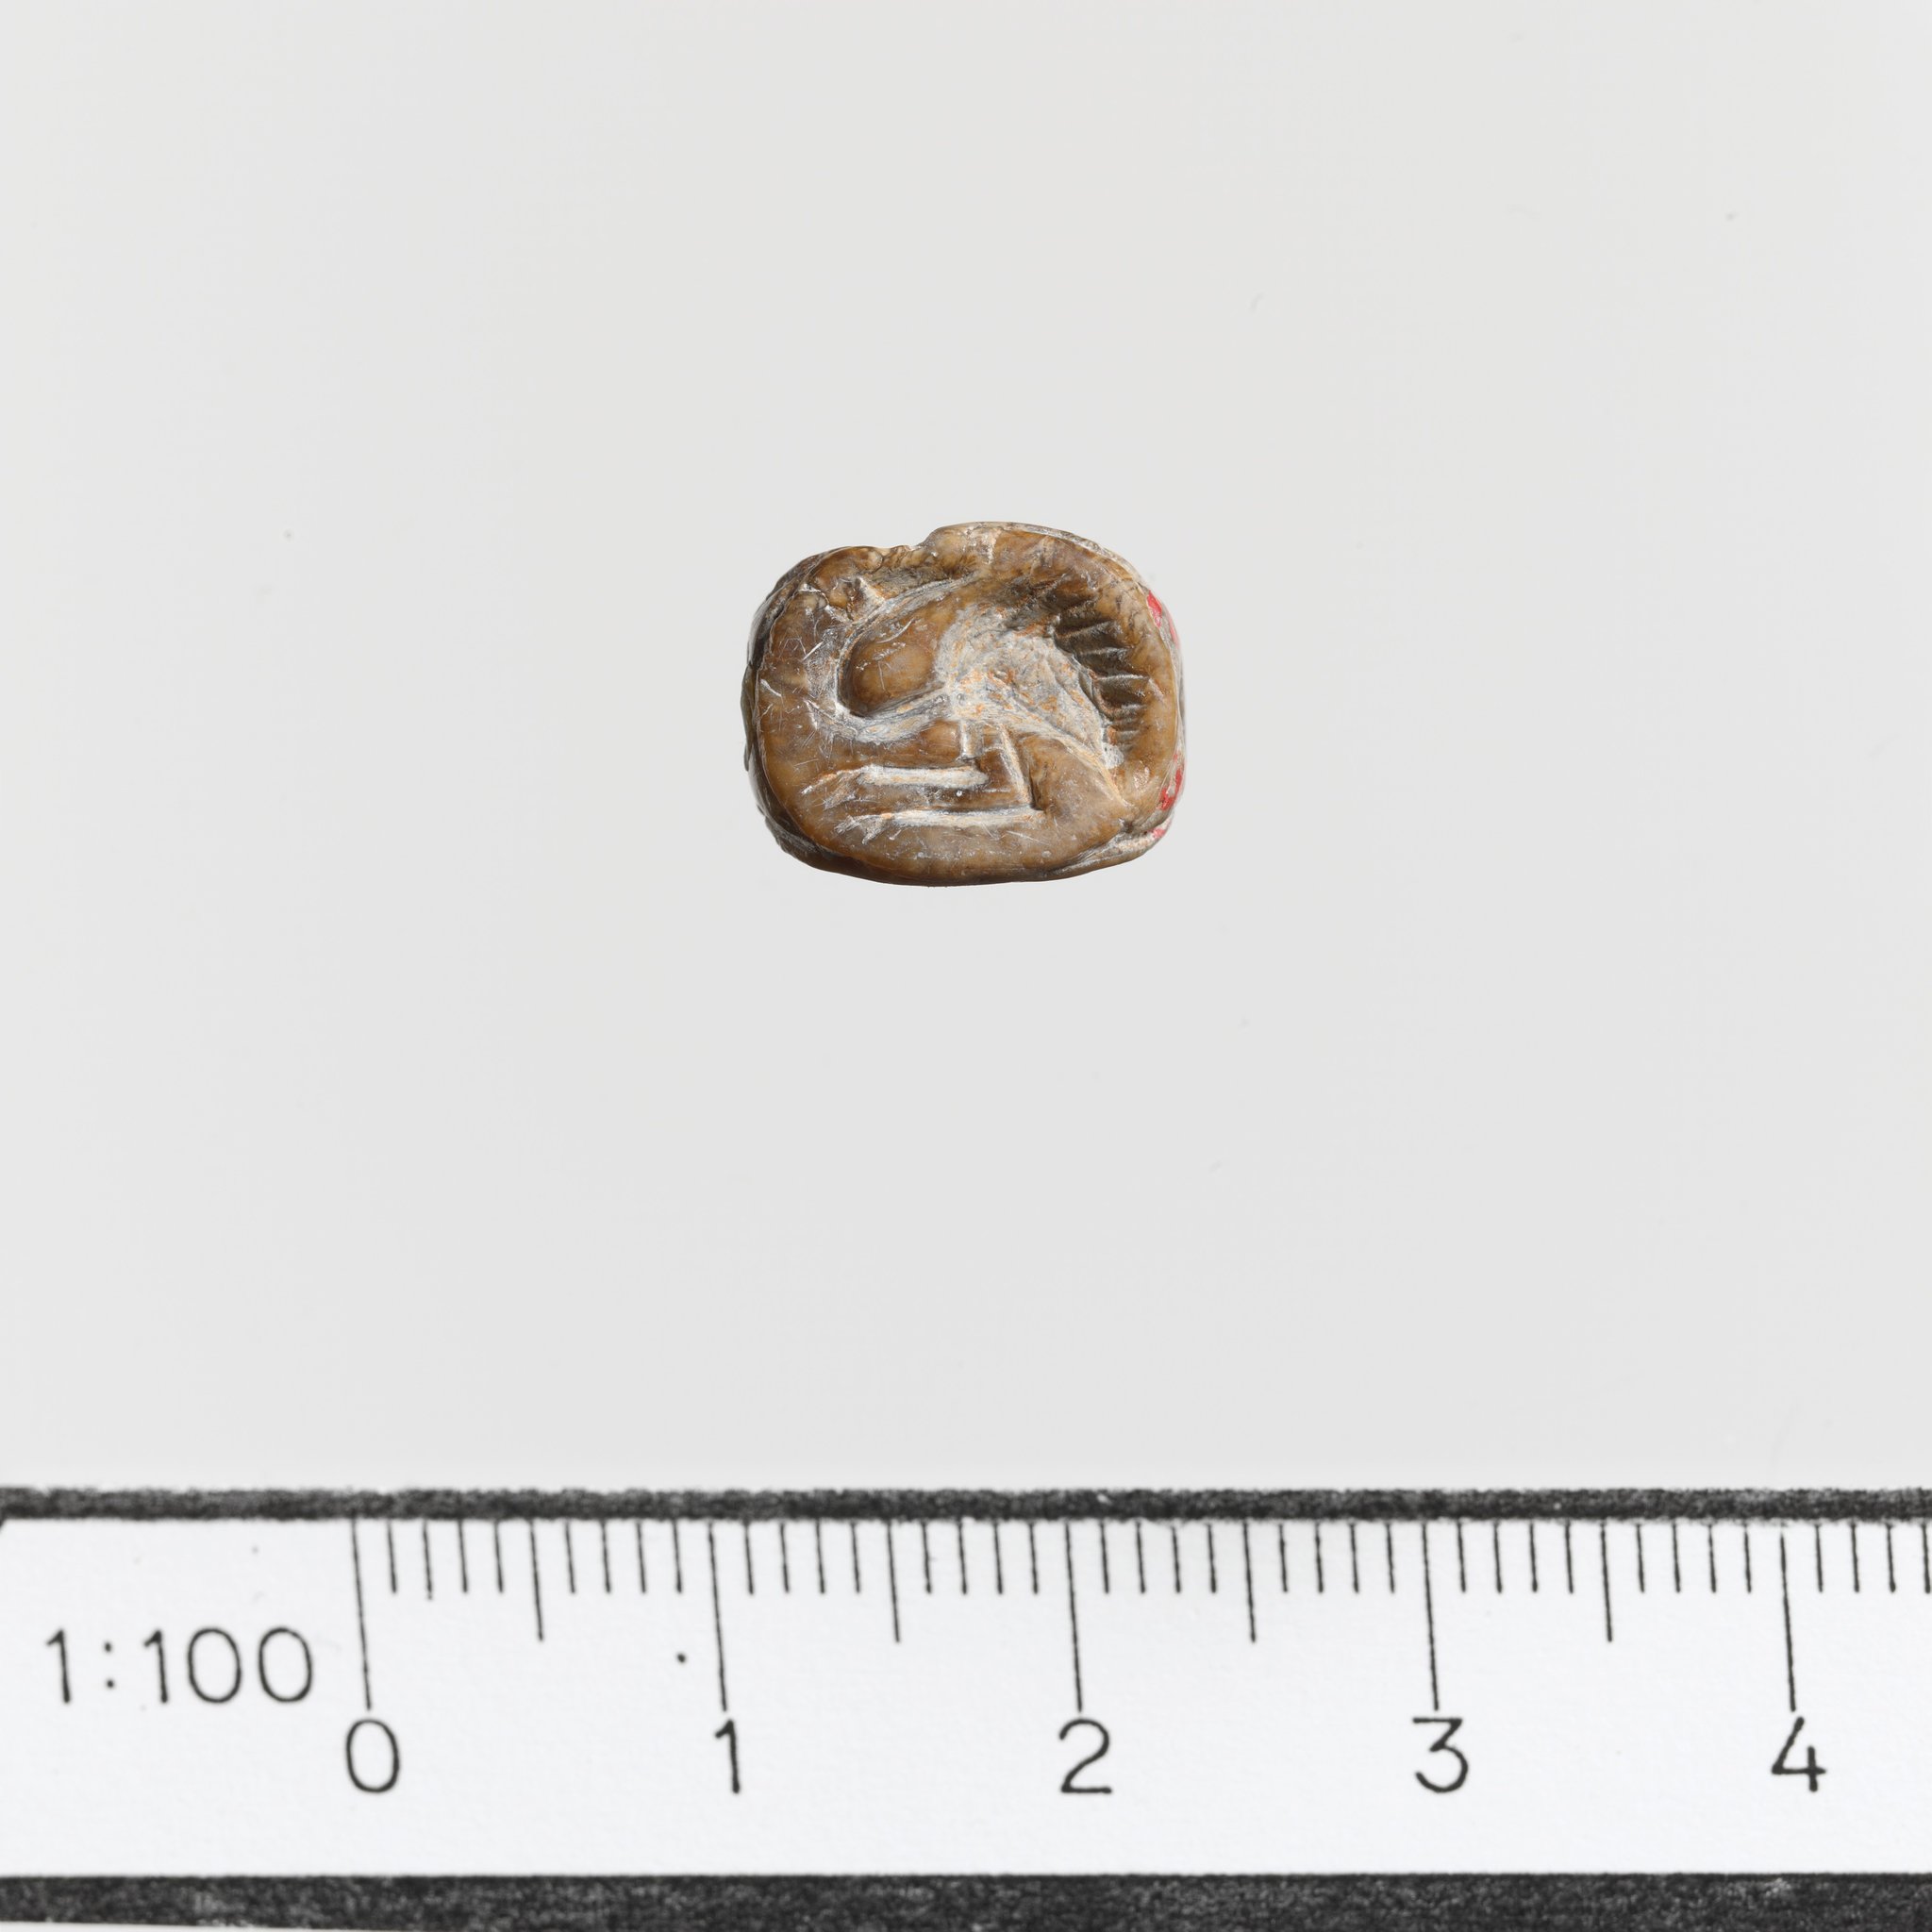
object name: seal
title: Steatite triangular prism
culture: minoan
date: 2400-1750 BCE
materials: stone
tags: birds